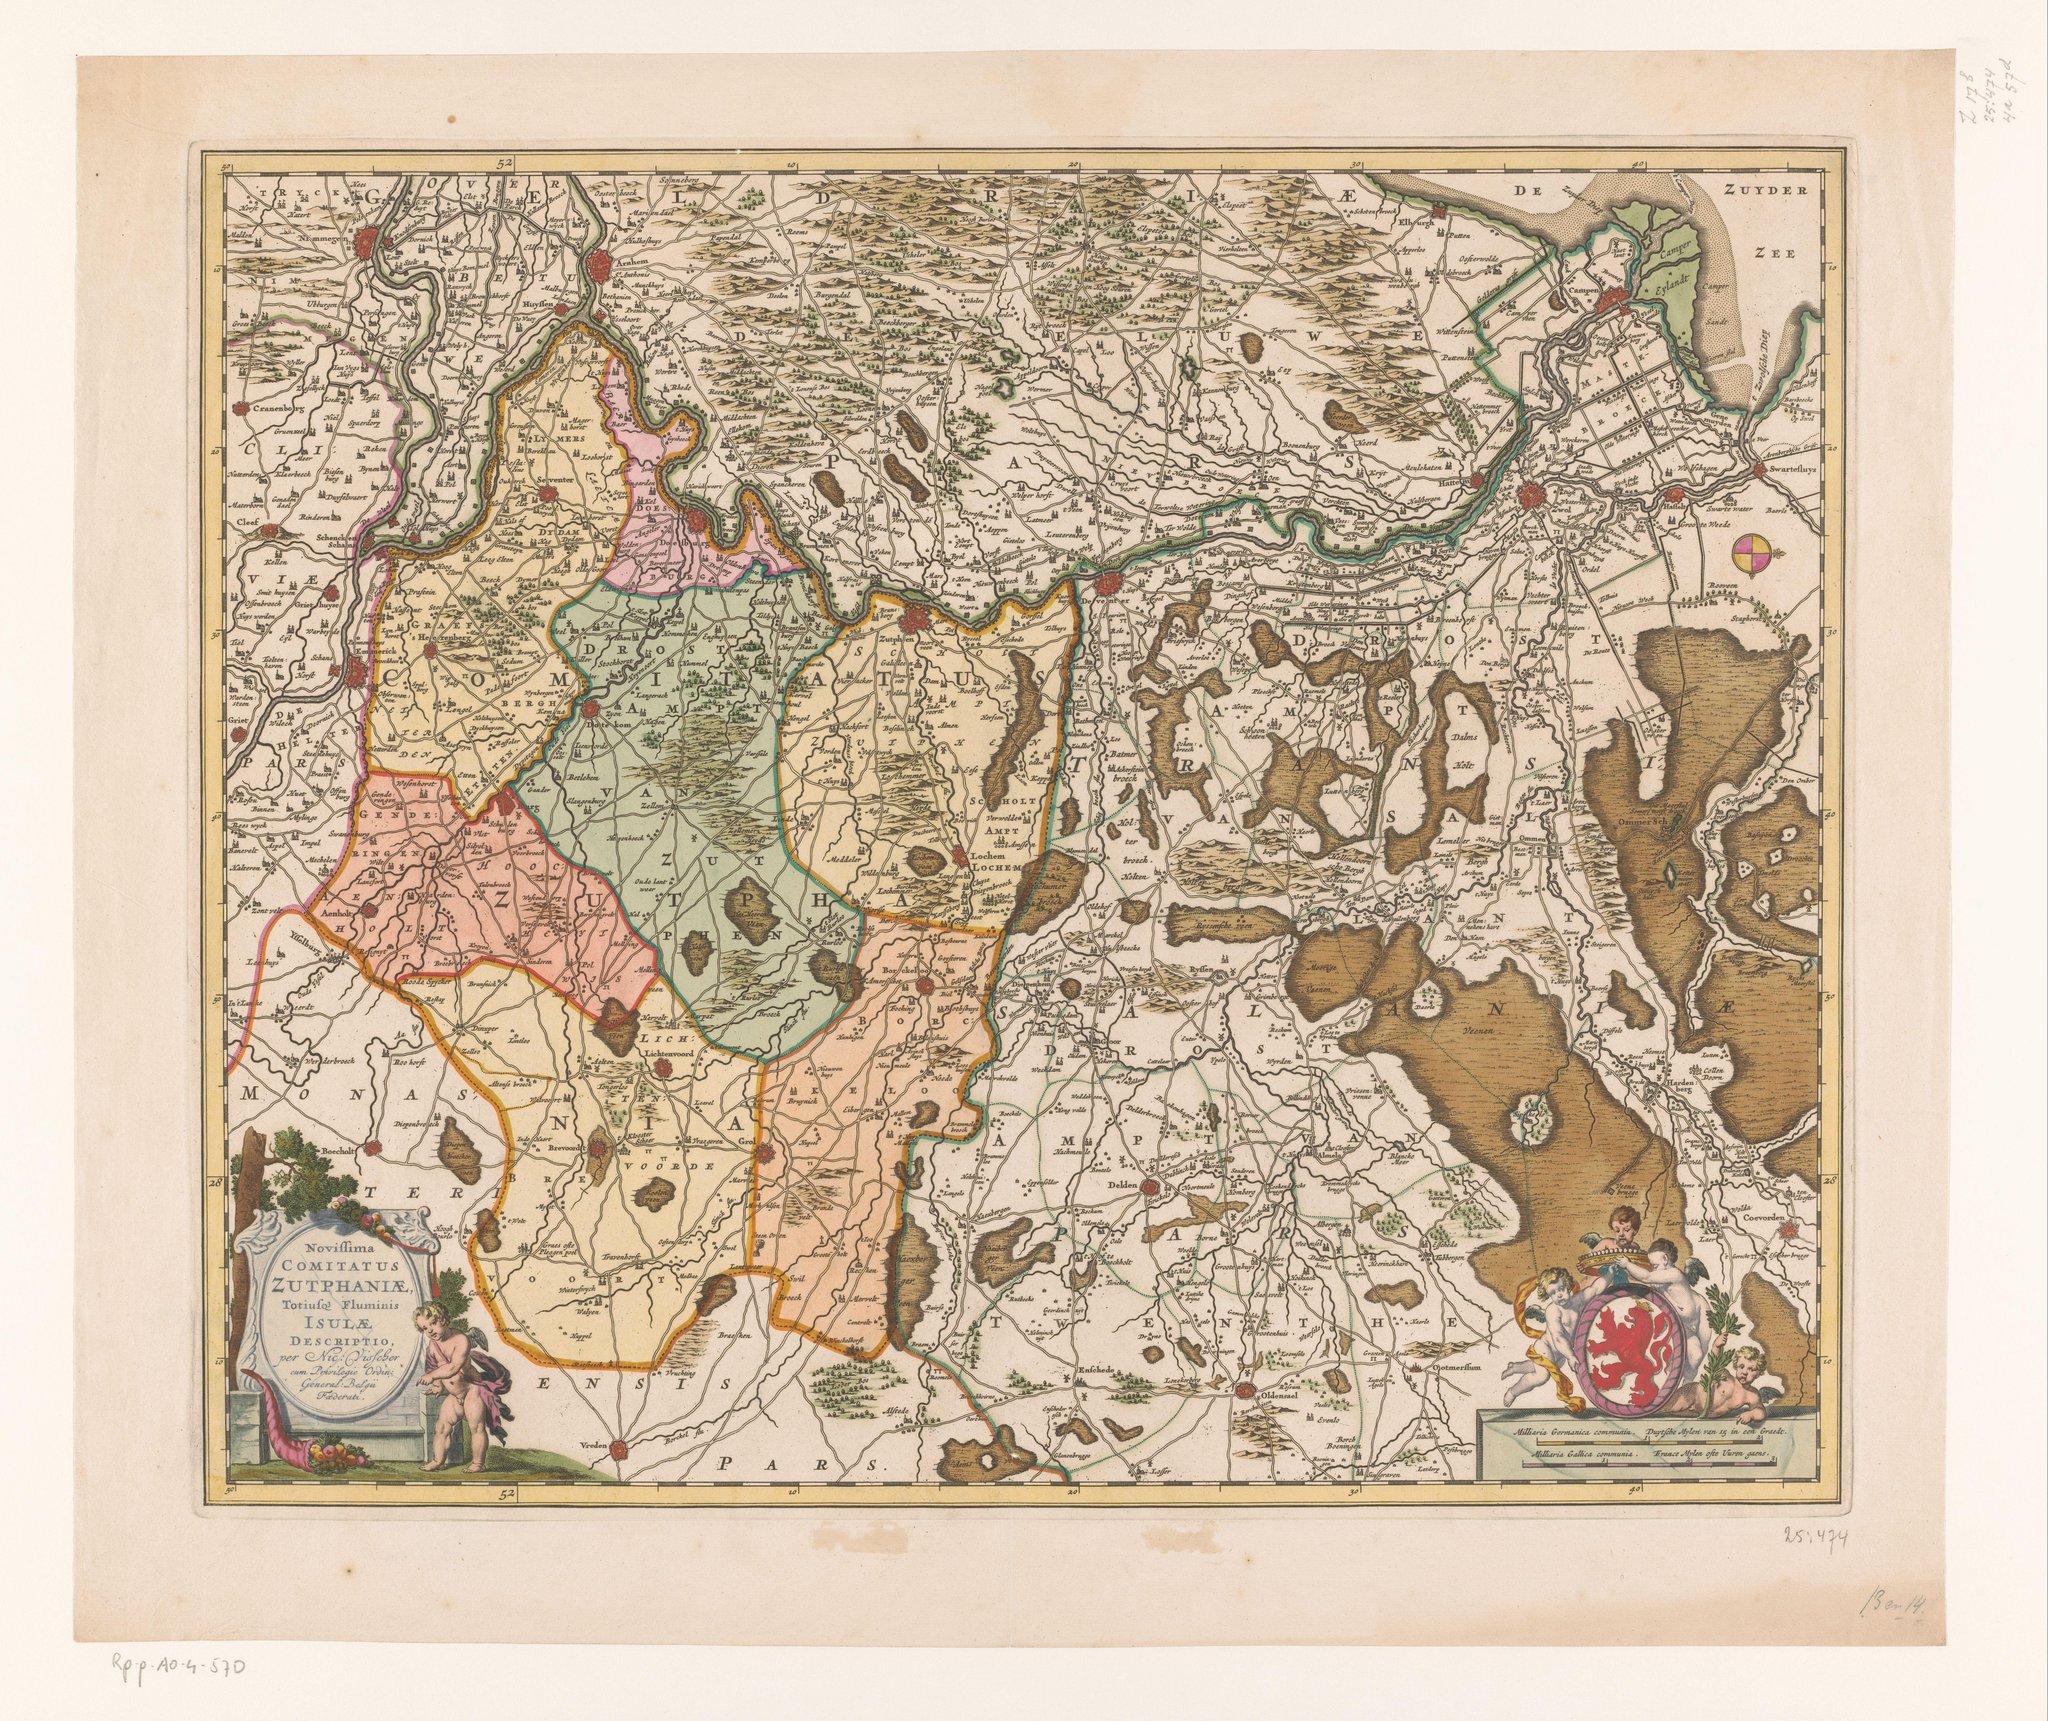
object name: map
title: Novissima comitatus Zutphaniae, totiusque fluminis isulae descriptio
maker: Anonymous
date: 1682-1720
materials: paper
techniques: engraving, etching, hand coloring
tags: maps of separate countries or regions, coat of arms (as symbol of the state, etc.) (+ province; provincial), gelderland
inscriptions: collector's mark: Lugt 2228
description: Linksonder de titelcartouche. Rechtsonder een cartouche met het wapen van het graafschap Zutphen en twee schaalstokken: 2 Duytsche Mylen van 15 in een Graedt / 3 Franc Mylen ofte Uuren gaens. De kaart is voorzien van een gradenverdeling langs de randen.